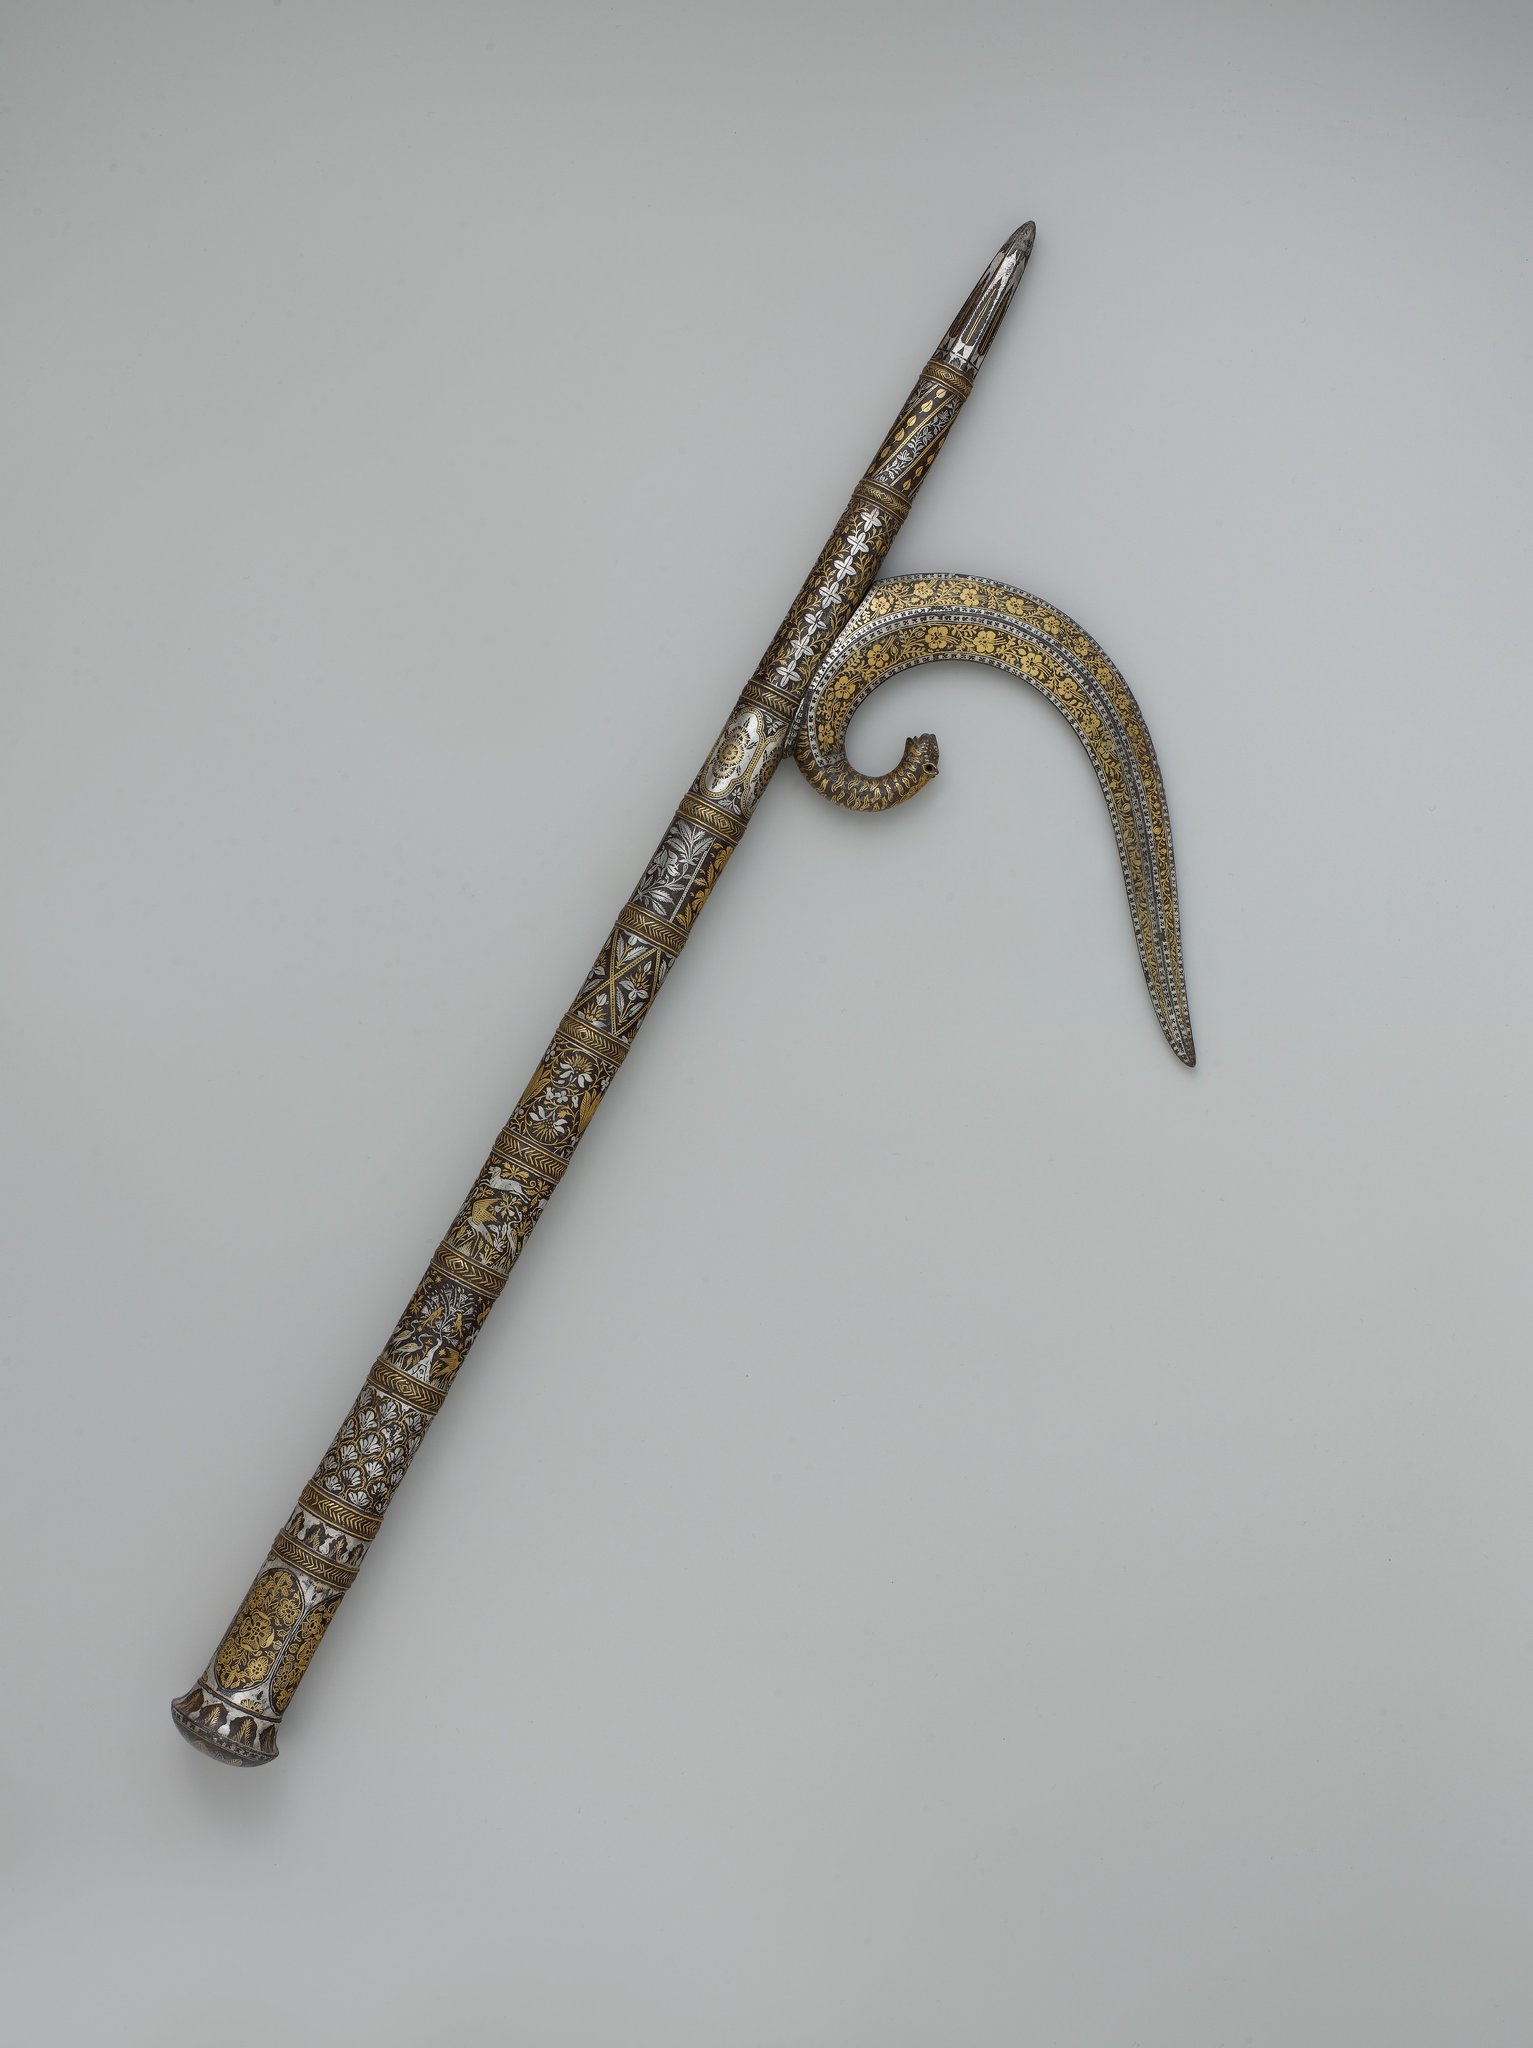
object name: elephant goad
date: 1667-1733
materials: gold, iron, silver, steel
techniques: inlay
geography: india